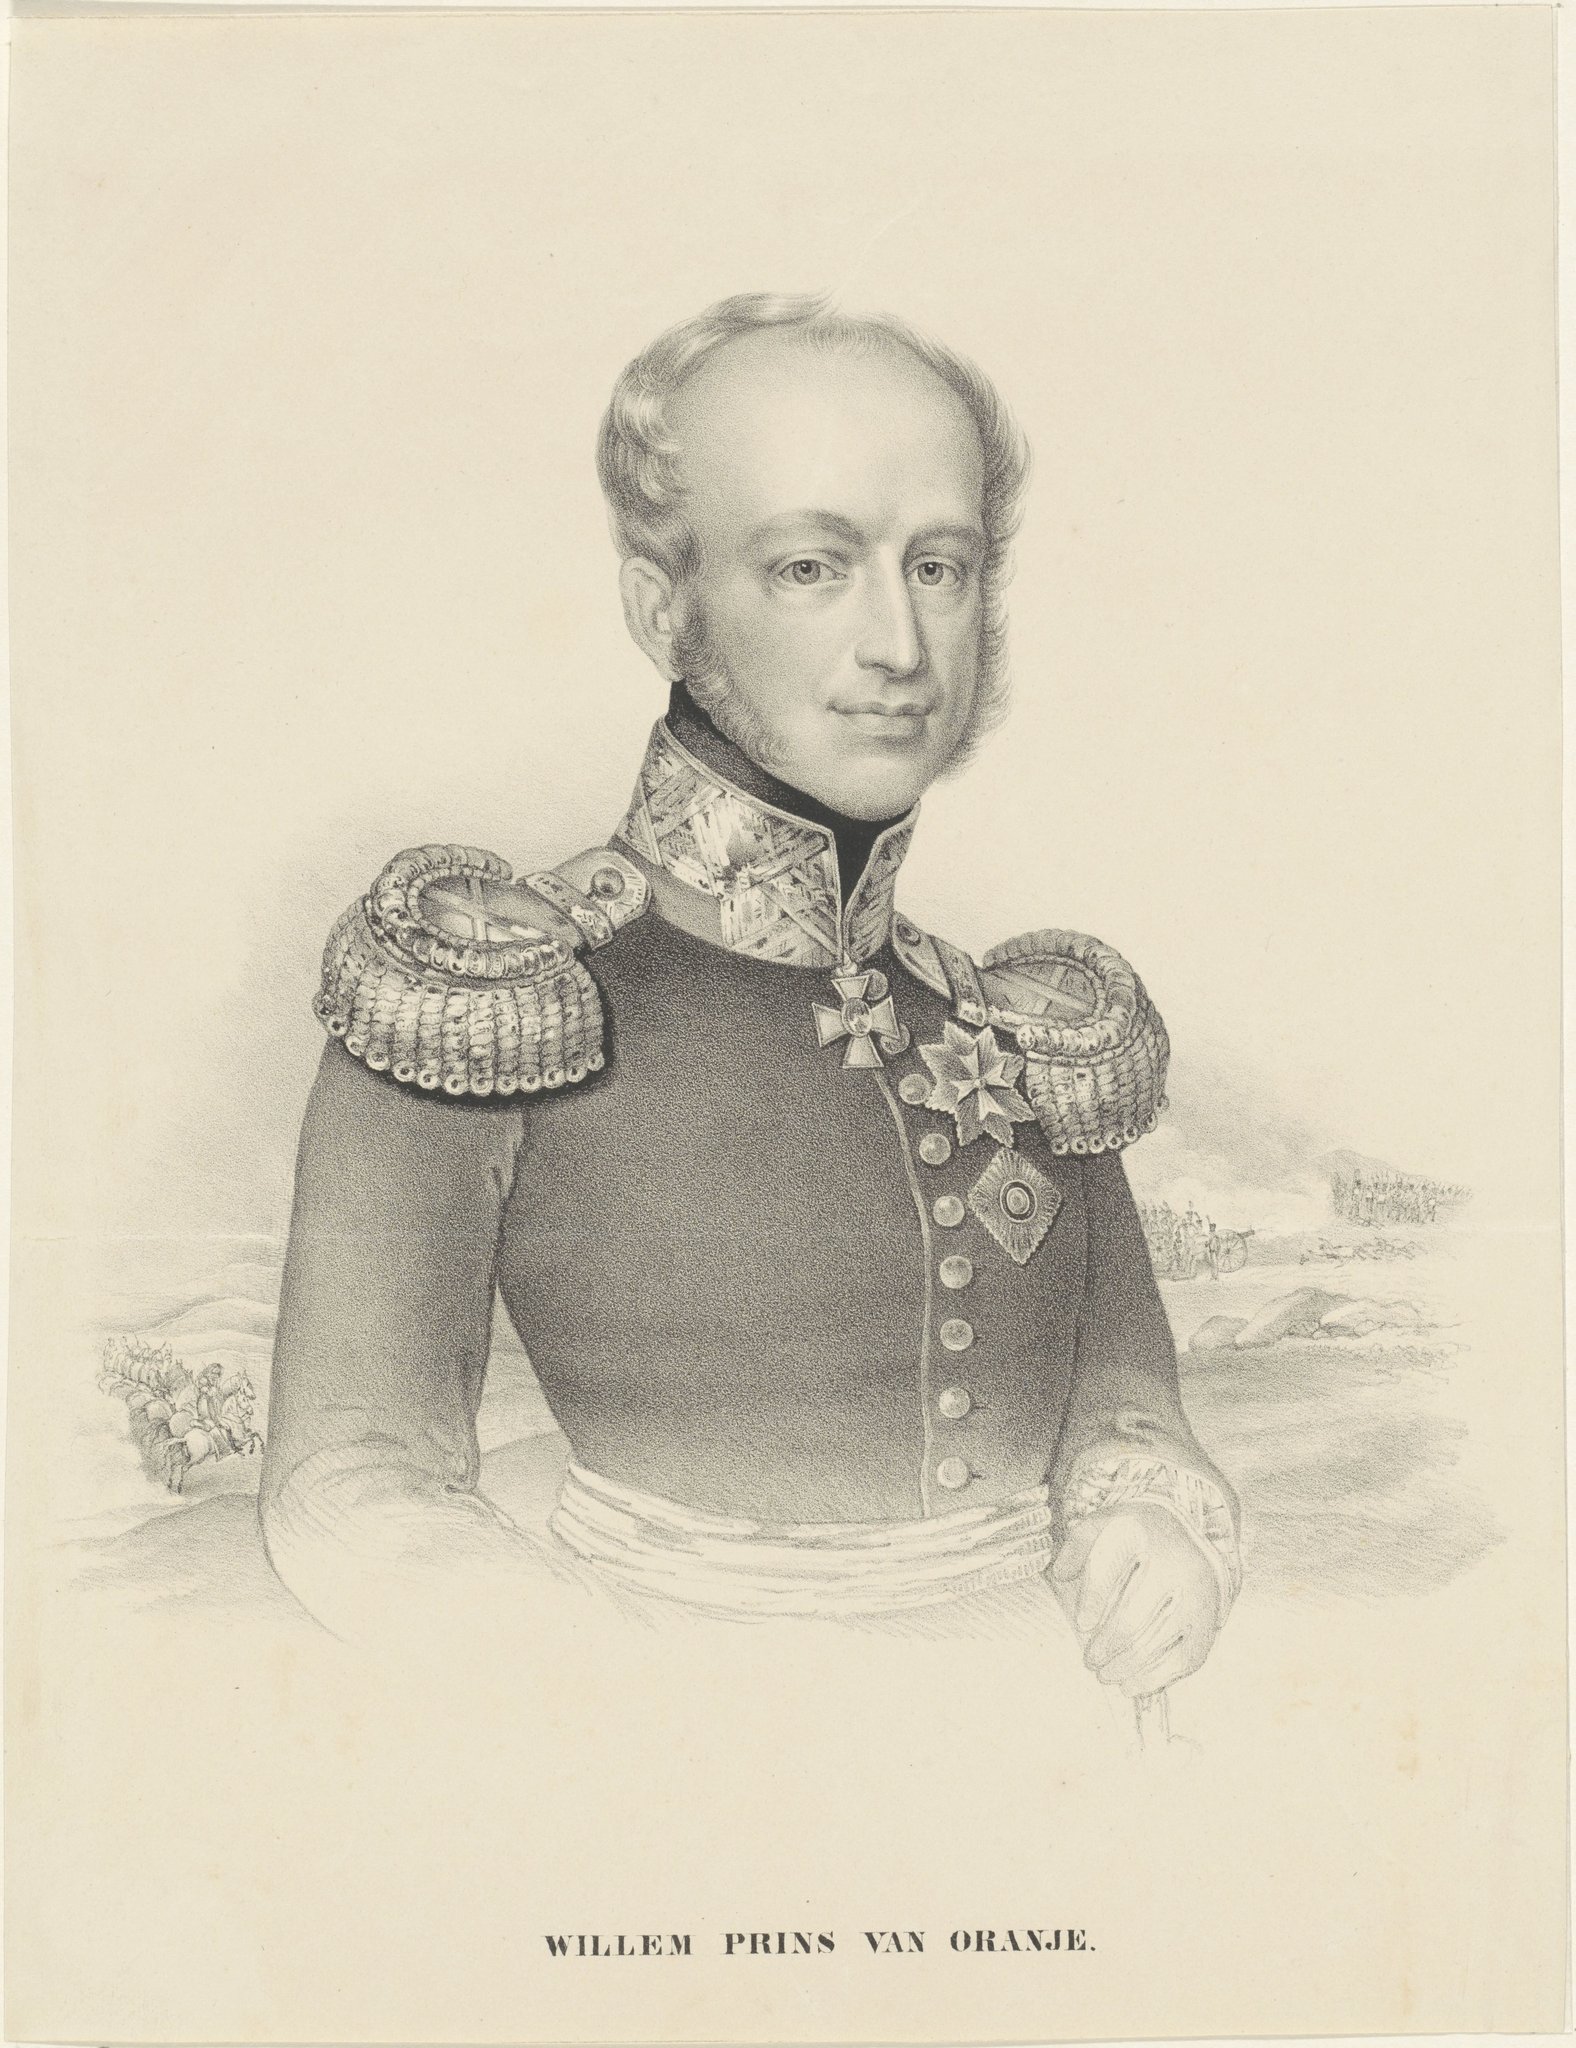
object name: print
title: Portret van Willem II, koning der Nederlanden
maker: Anonymous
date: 1810-1899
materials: paper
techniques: lithograph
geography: low countries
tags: the hague, william ii of the netherlands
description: De hier vermelde titel verwijst naar de hoogst verkregen titel van de geportretteerde, niet per se naar de titel die de geportretteerde op deze voorstelling draagt.